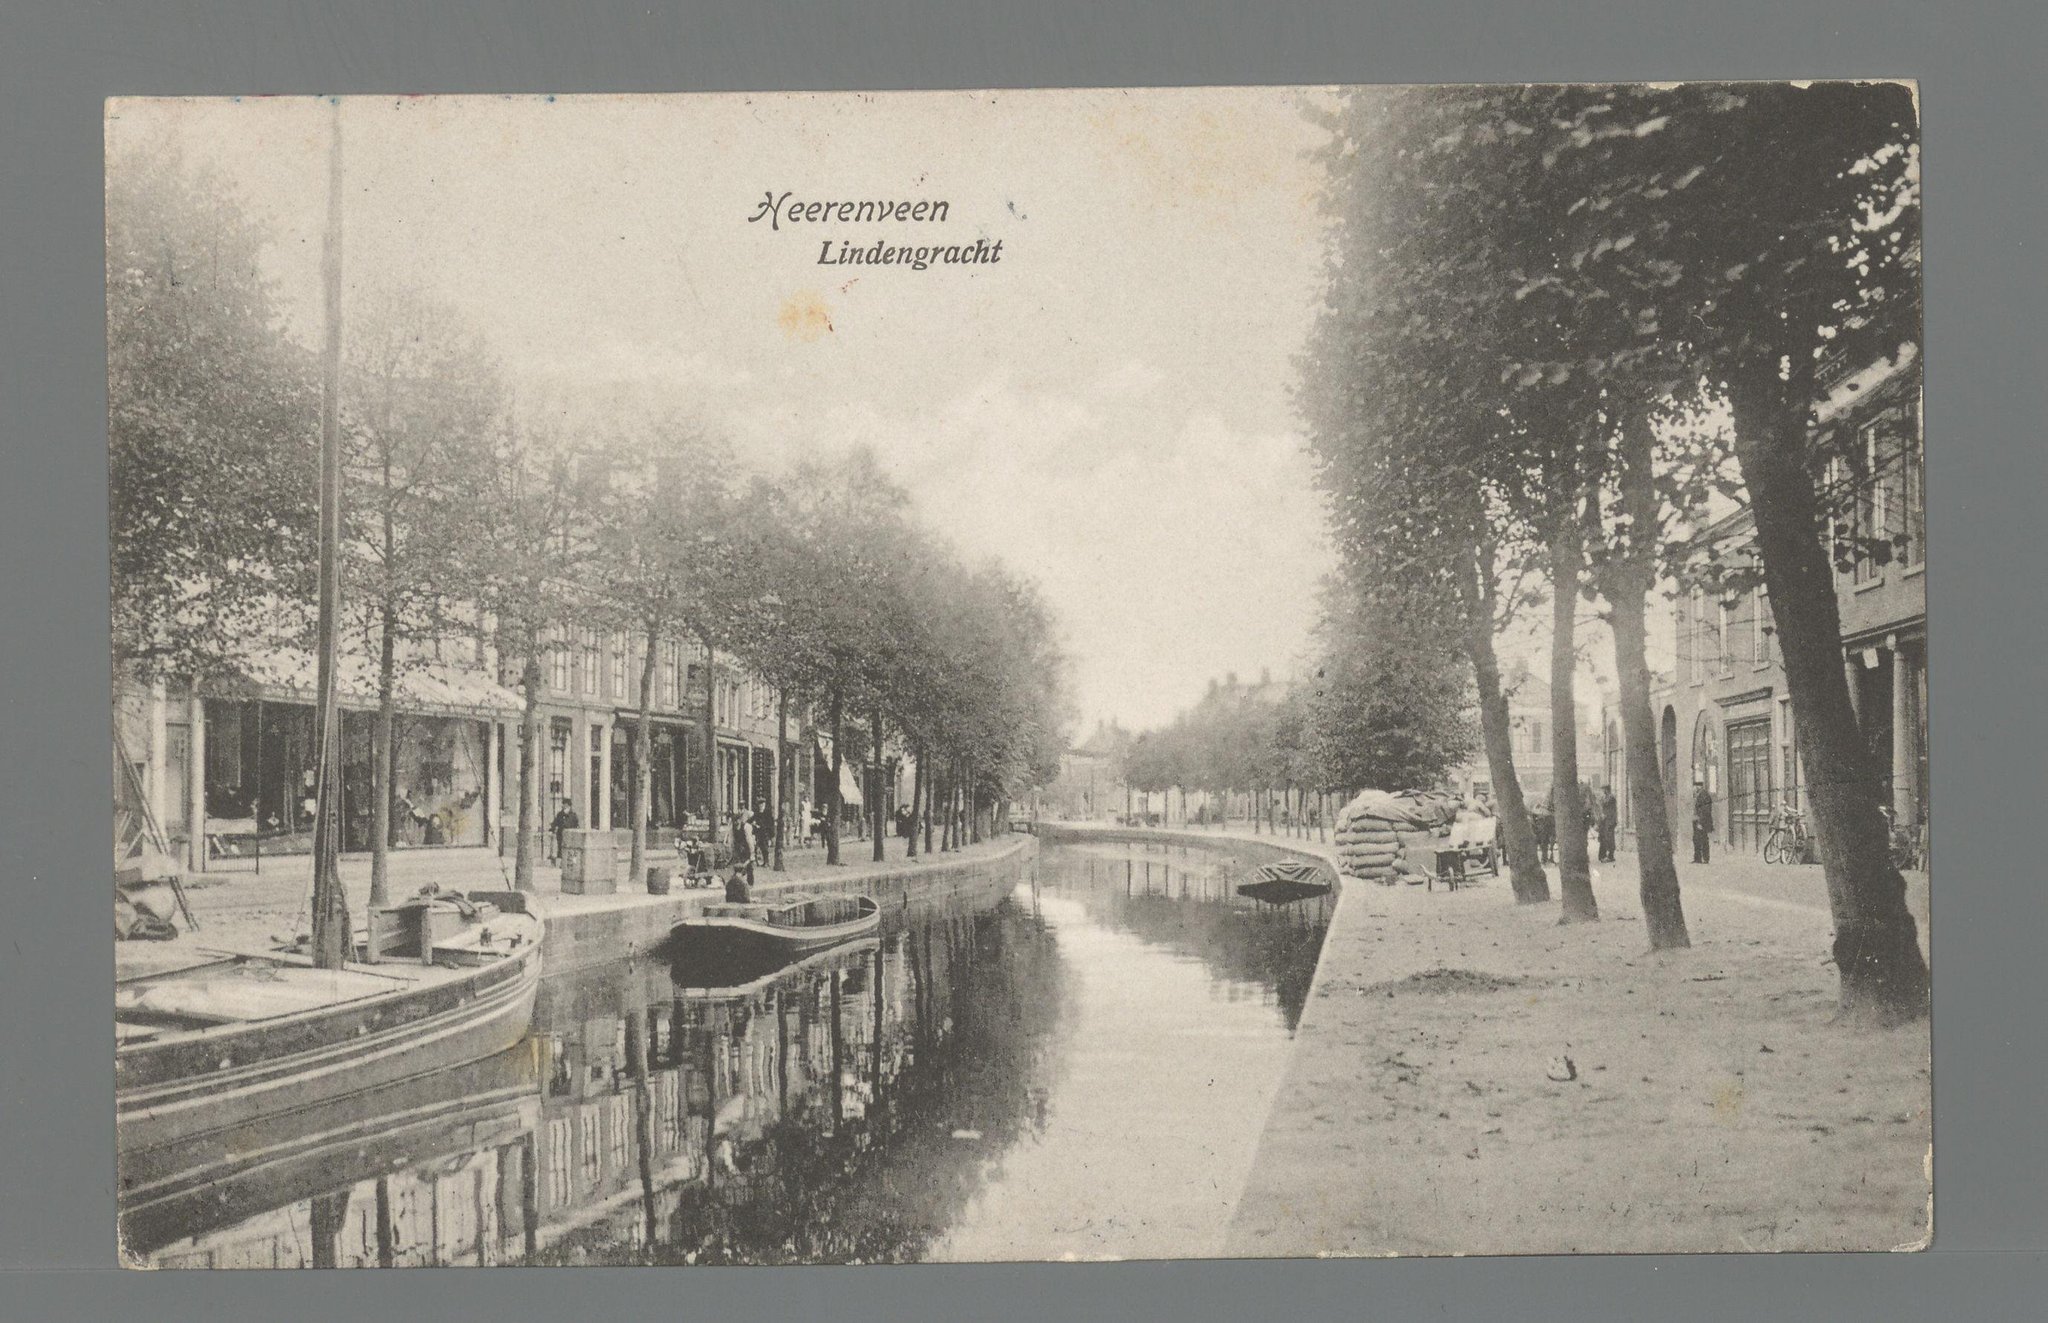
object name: photomechanical print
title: Heerenveen. Lindengracht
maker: Anonymous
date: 1913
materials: cardboard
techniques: photograph, writing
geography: heerenveen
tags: canal, street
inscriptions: poststempel, verso, gestempeld